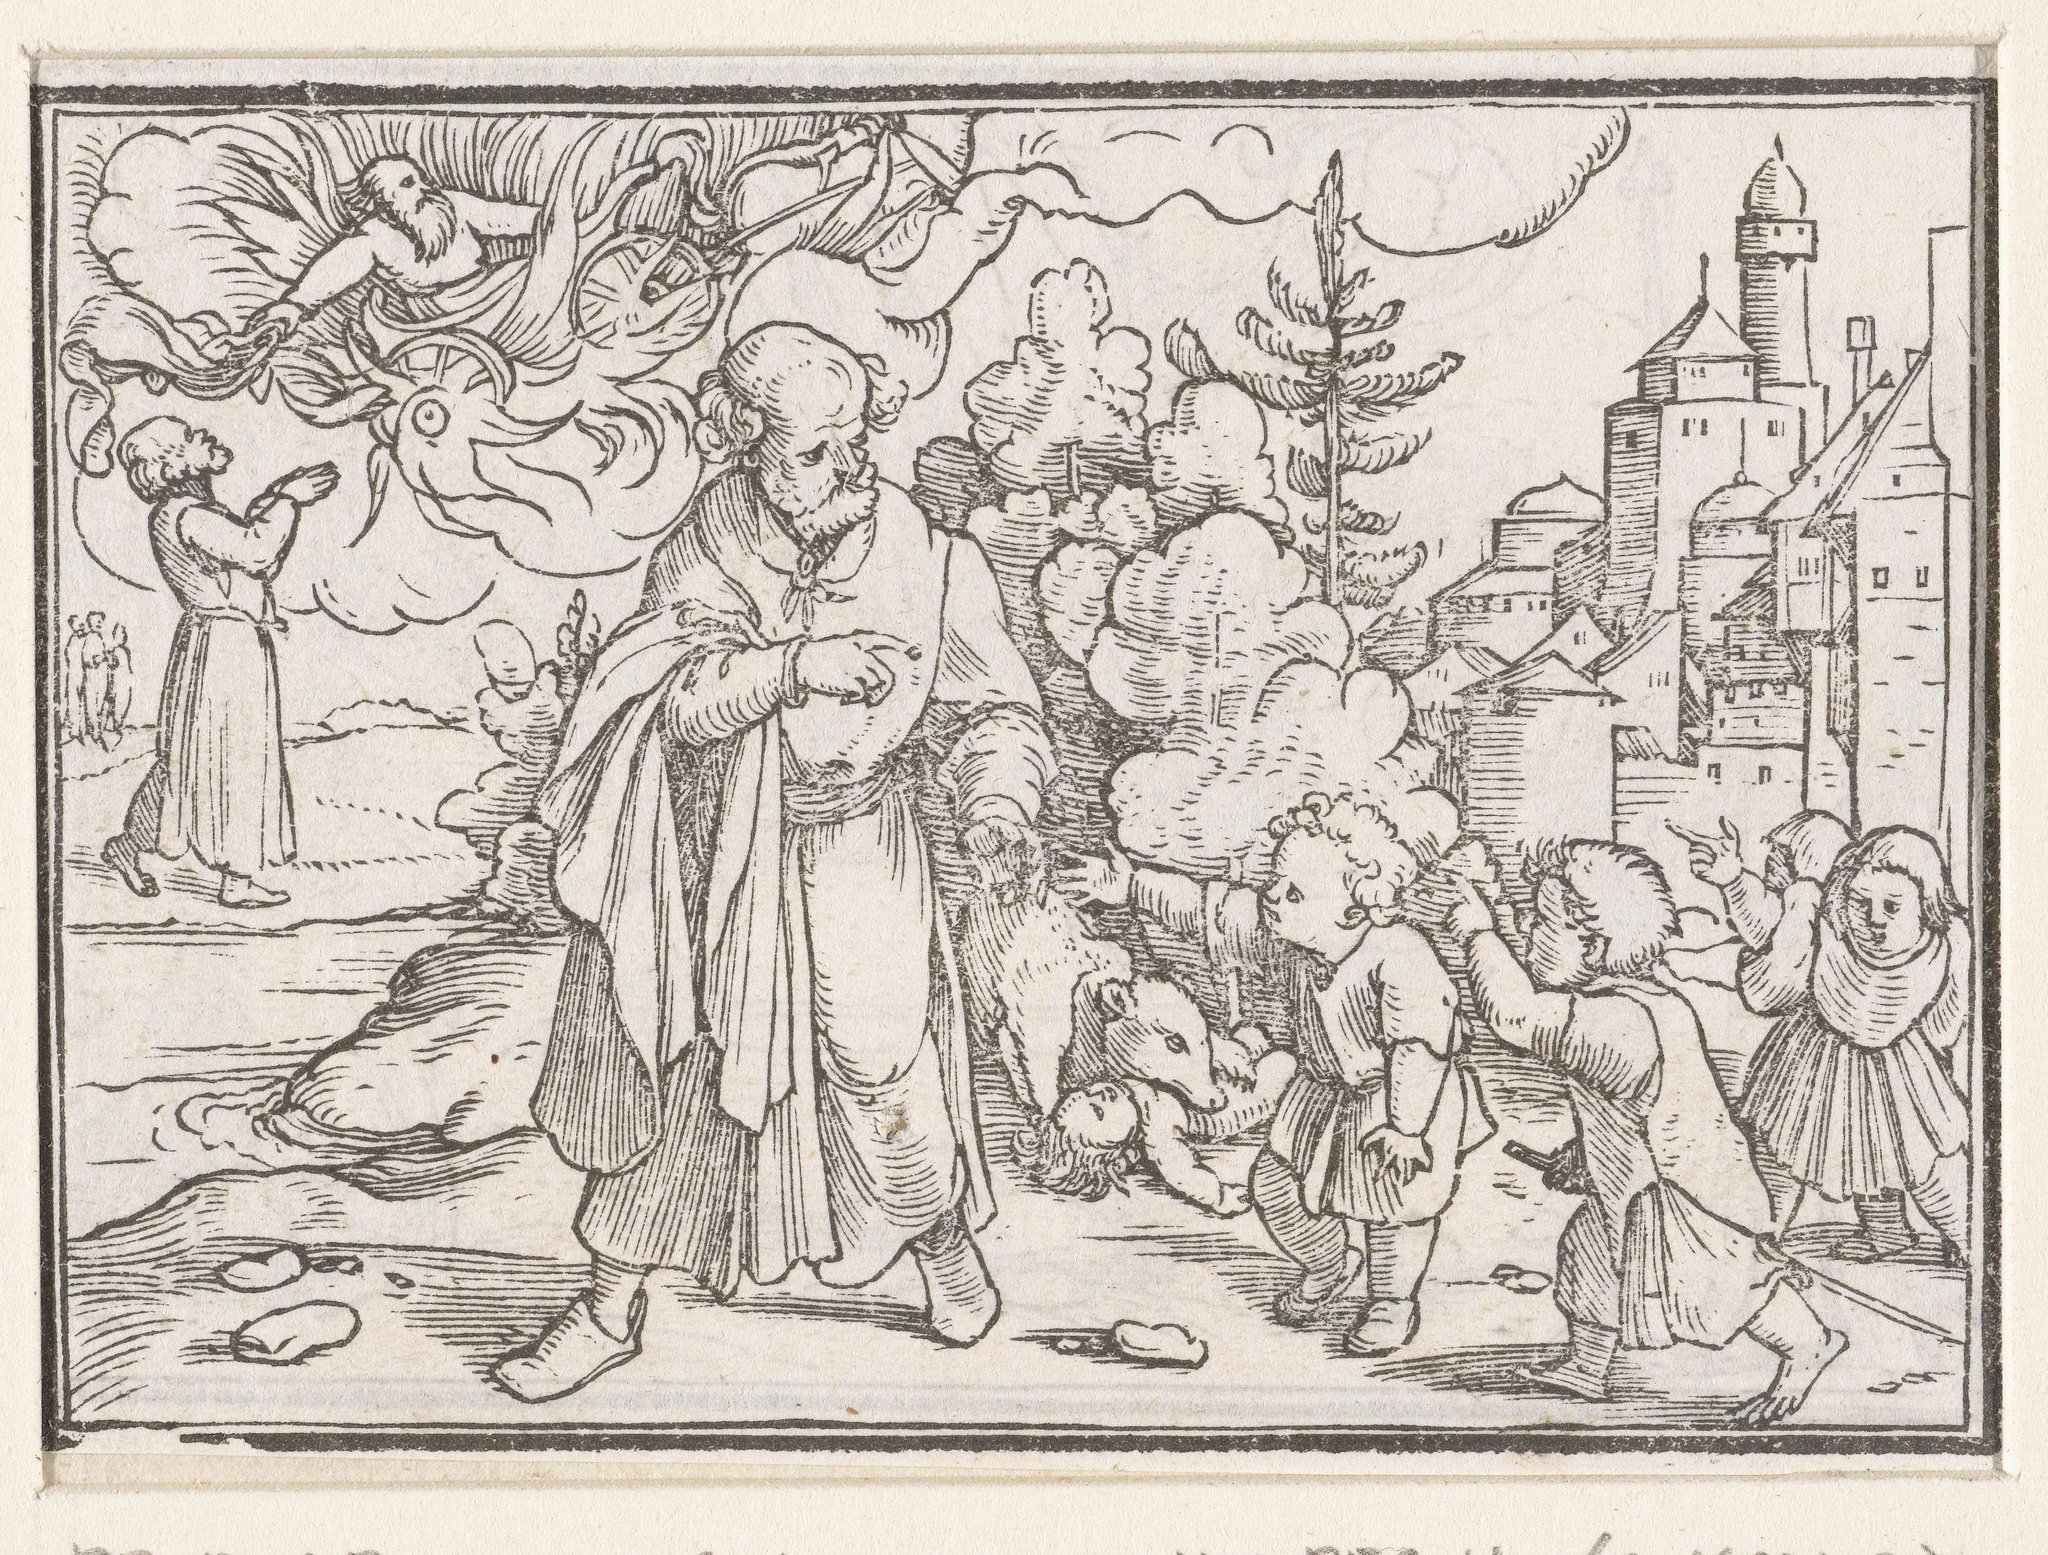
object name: print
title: Bestraffing van de kinderen die Elisa bespotten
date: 1538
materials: paper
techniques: woodcut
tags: the ascension of elijah (2 kings 2:1-18), the cursing of the children: when elisha is on his way some children mock him for his baldness; elisha curses them (2 kings 2:23-25)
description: Elisa wordt op weg naat Betel uitgescholden door kinderen voor kaalkop en hij straft hen, ze worden verslonden door beren. Op de achtergrond is een andere scène weergegeven. Elisa is getuige van het moment waarop Elia in een wagen van vuur wordt meegenomen in de hemel. In de marge boven de afbeelding staat de tekst IIII Regvm II [2 Koningen 2].